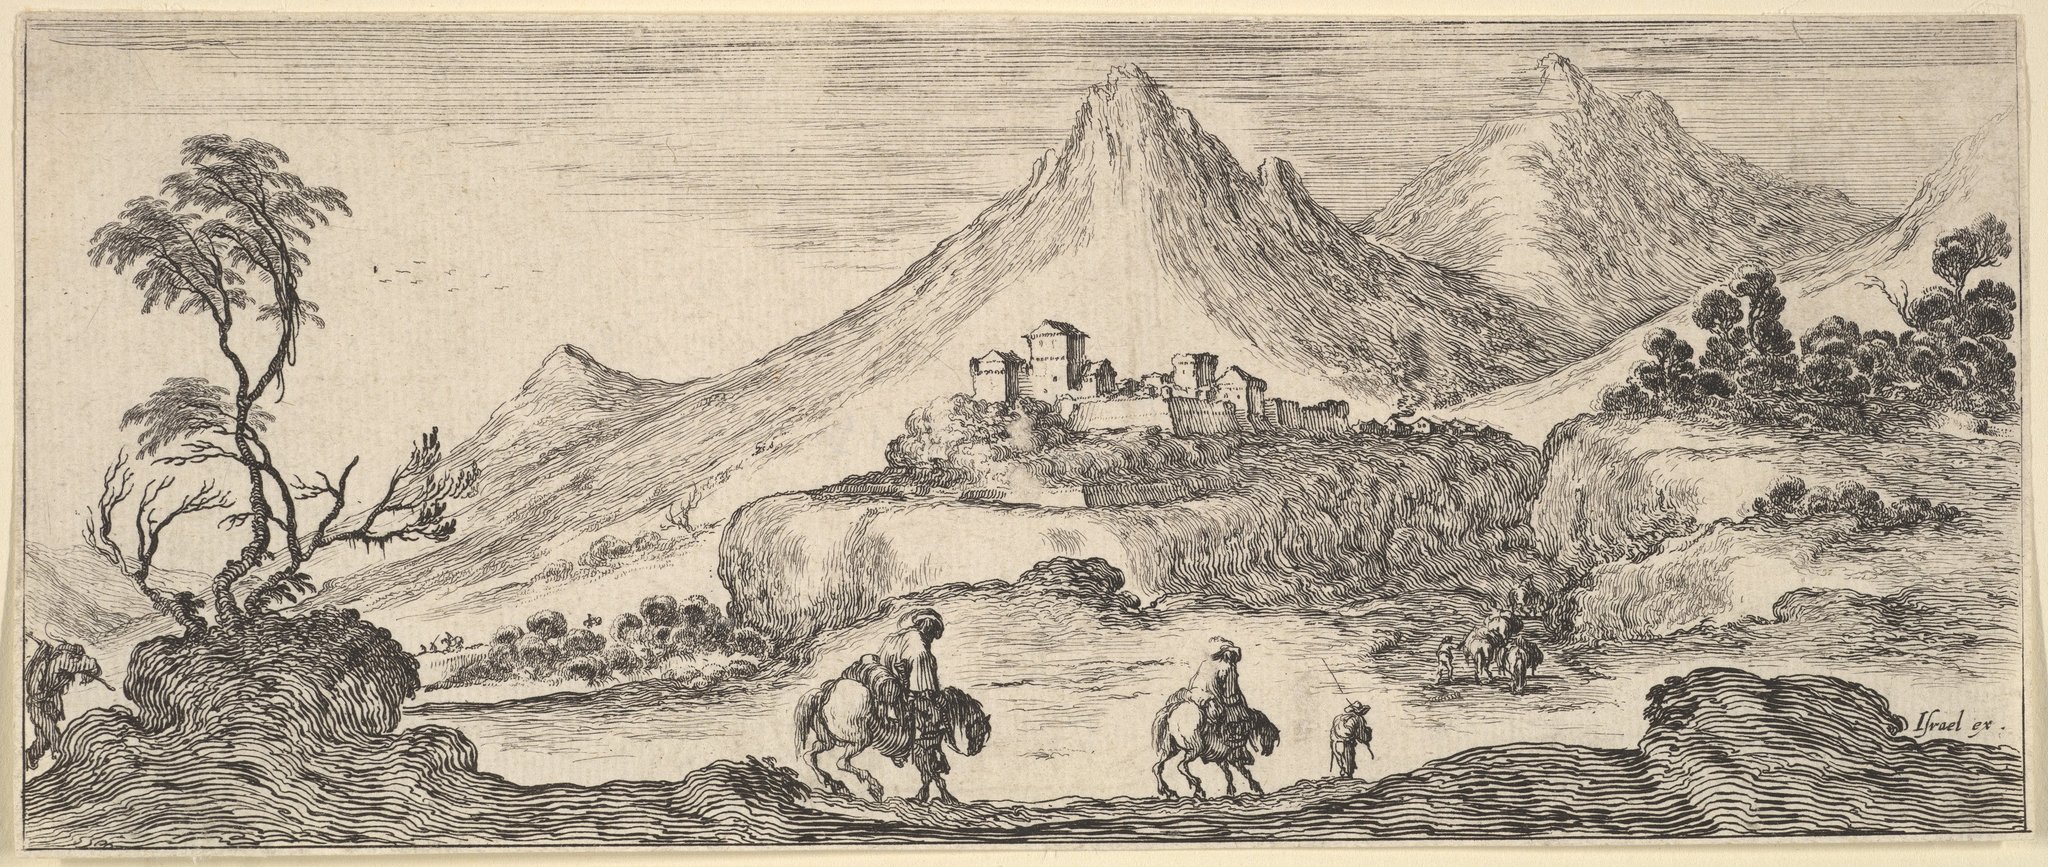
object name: print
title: Two horsemen descend a hill in center, following another man on foot, a castle in the mountains in the center background, from "Various Landscapes" (Divers Paysages)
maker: stefano della bella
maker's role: artist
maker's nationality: italian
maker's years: 1610-1664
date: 1641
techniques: etching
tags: castles,men,horses,mountains,landscapes